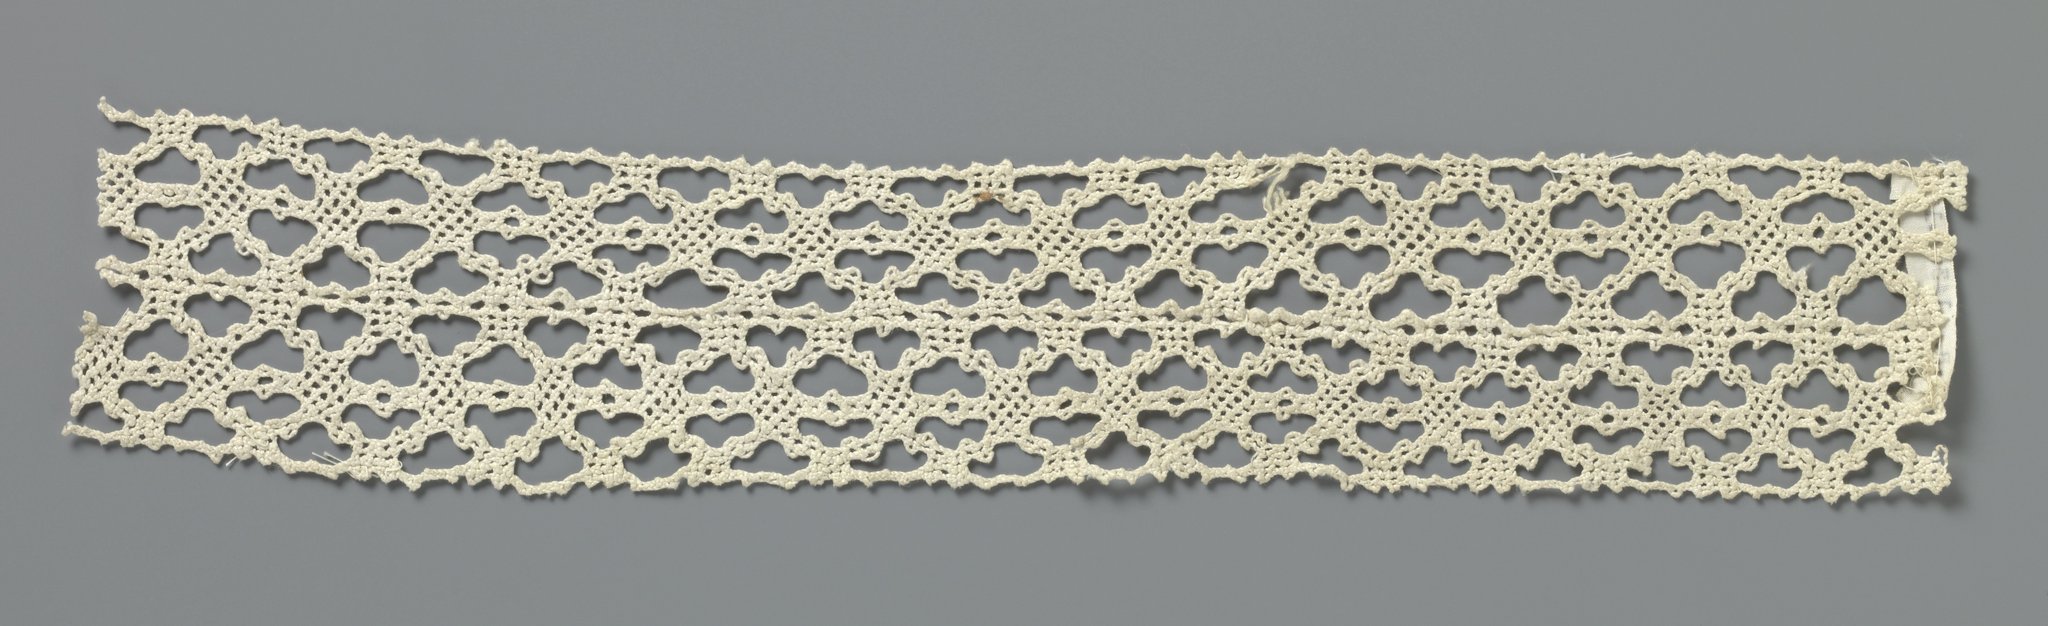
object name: entre deux, tussenzetsel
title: Tussenzetsel van een dubbele strook kloskant met zeshoeken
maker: Anonymous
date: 1890-1899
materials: linen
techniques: lace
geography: italy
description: Tussenzetsel van naturelkleurige kloskant, gemaakt van twee in de lengte aan elkaar genaaide stroken. Het patroon is gebaseerd op een zestiende-eeuws voorbeeld en doet denken aan reticella. Het bestaat per strook uit een rij zeshoeken gemaakt met een dichte maasgrond die met vlechtwerkjes vanuit de hoeken aan elkaar verbonden zijn. Het patroon loopt door in de boven- en onderrand, maar wordt daar halverwege onderbroken door een rechte afwerking met picots. Het patroon op de middenlijn, waar de stroken aan elkaar genaaid zijn, past niet precies op elkaar.